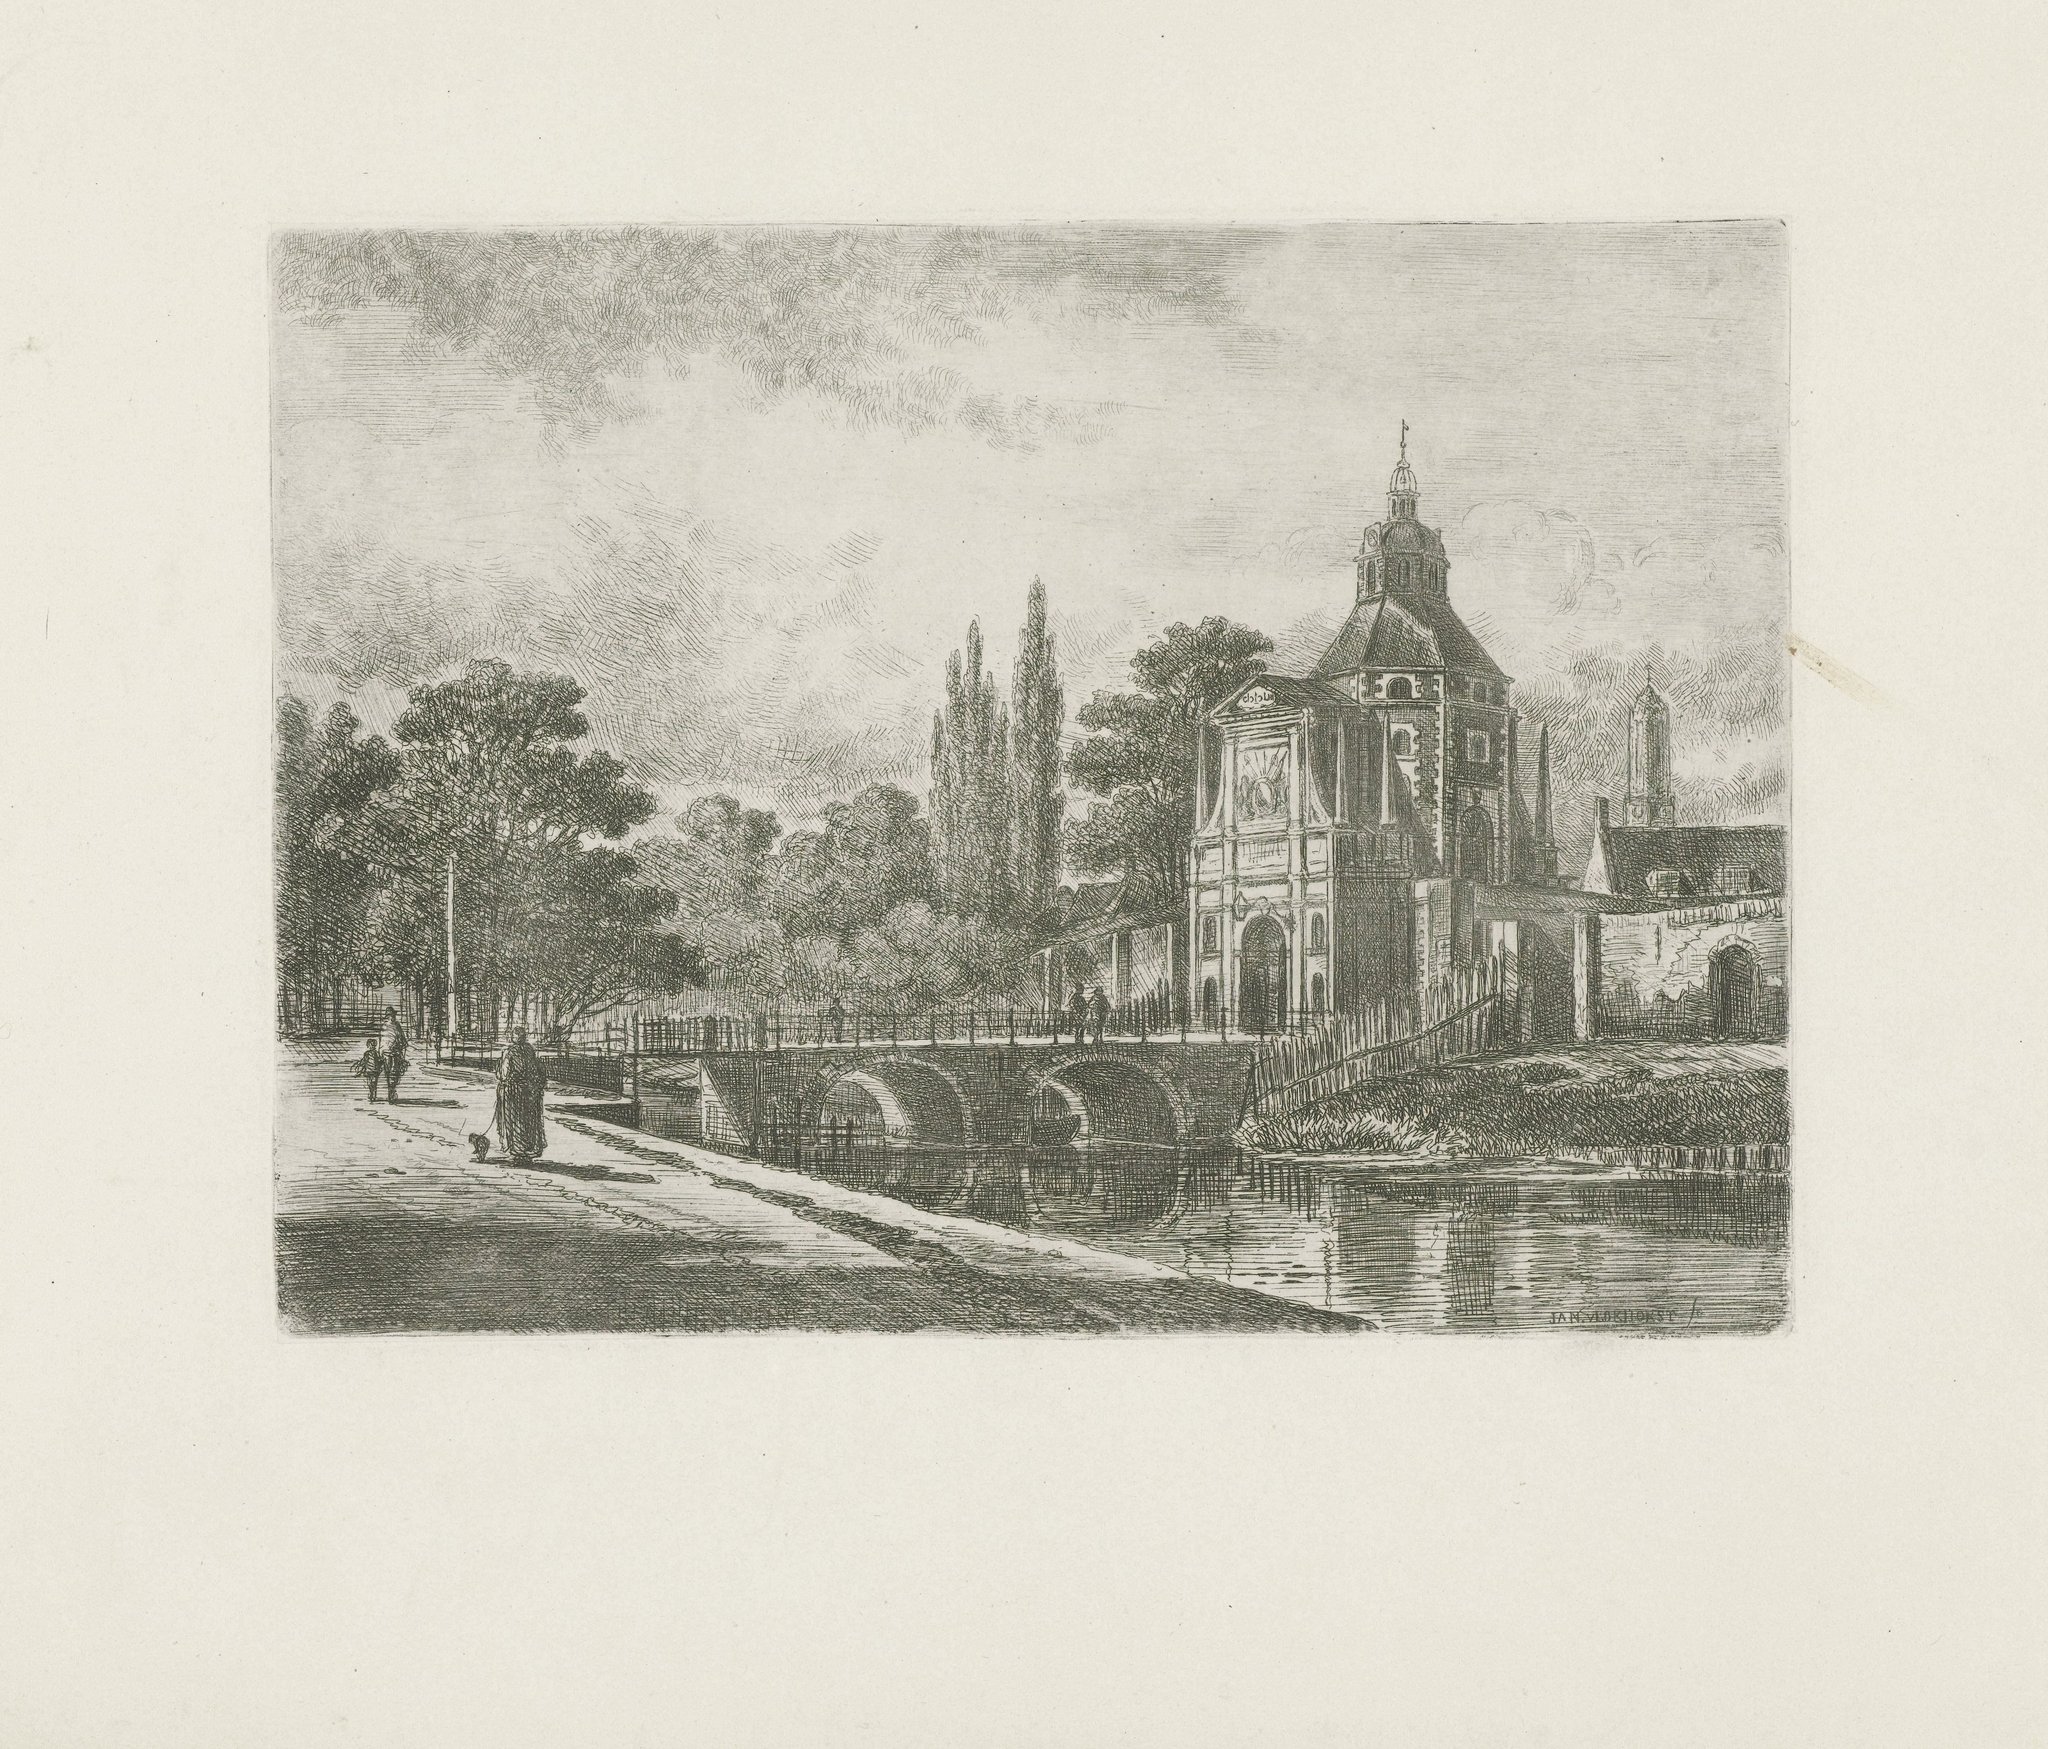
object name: print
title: Wittevrouwenpoort te Utrecht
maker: jan van lokhorst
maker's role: draughtsman, print maker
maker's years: 1837-1894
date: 1847-1874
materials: paper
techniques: etching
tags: city-walls, city-gate (+ city(-scape) with figures, staffage)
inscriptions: collector's mark: Lugt 2228, collector's mark: Lugt 2760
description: Gezicht op de Wittevrouwenpoort te Utrecht, gezien van buiten de stadsmuur. Links lopen enkele figuren op een weg langs de Wittevrouwensingel.